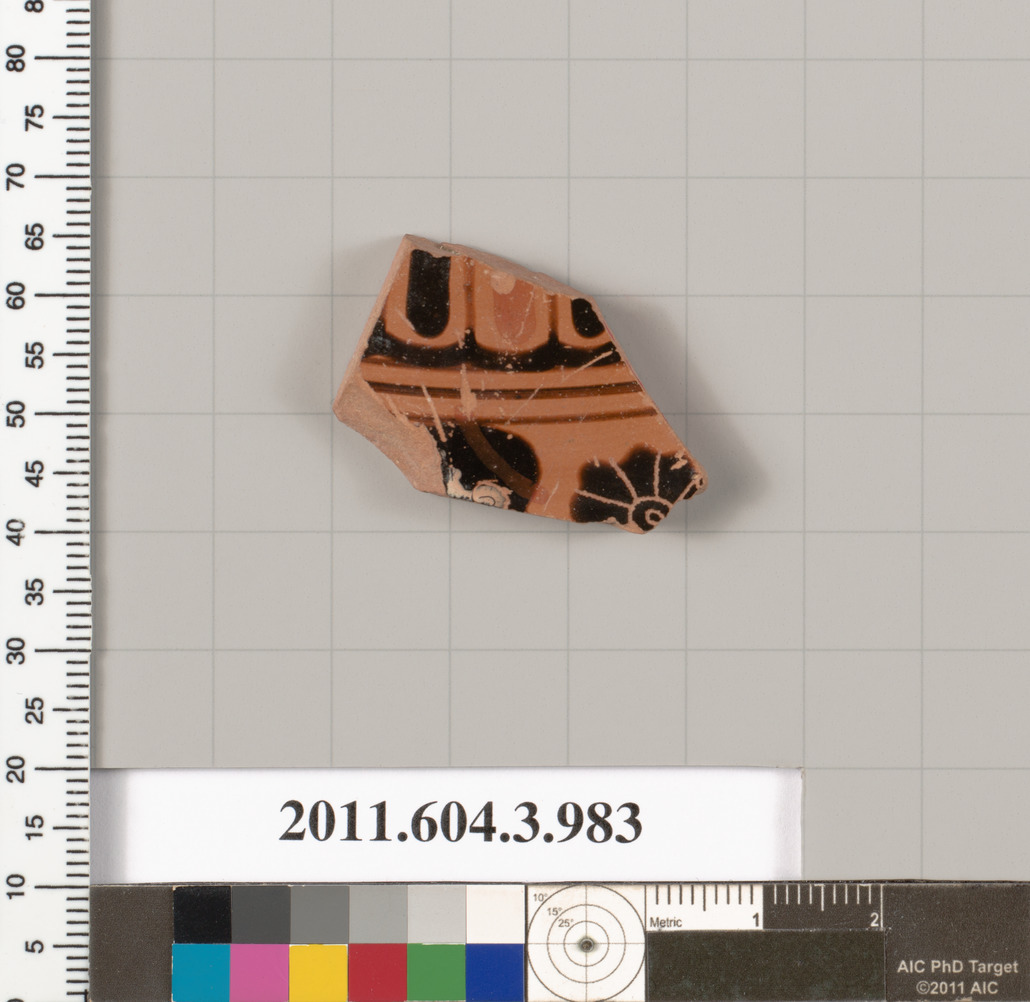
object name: lekanis lid fragment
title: Terracotta fragment of a lekanis lid (covered dish)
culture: greek, attic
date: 575-551 BCE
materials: terracotta